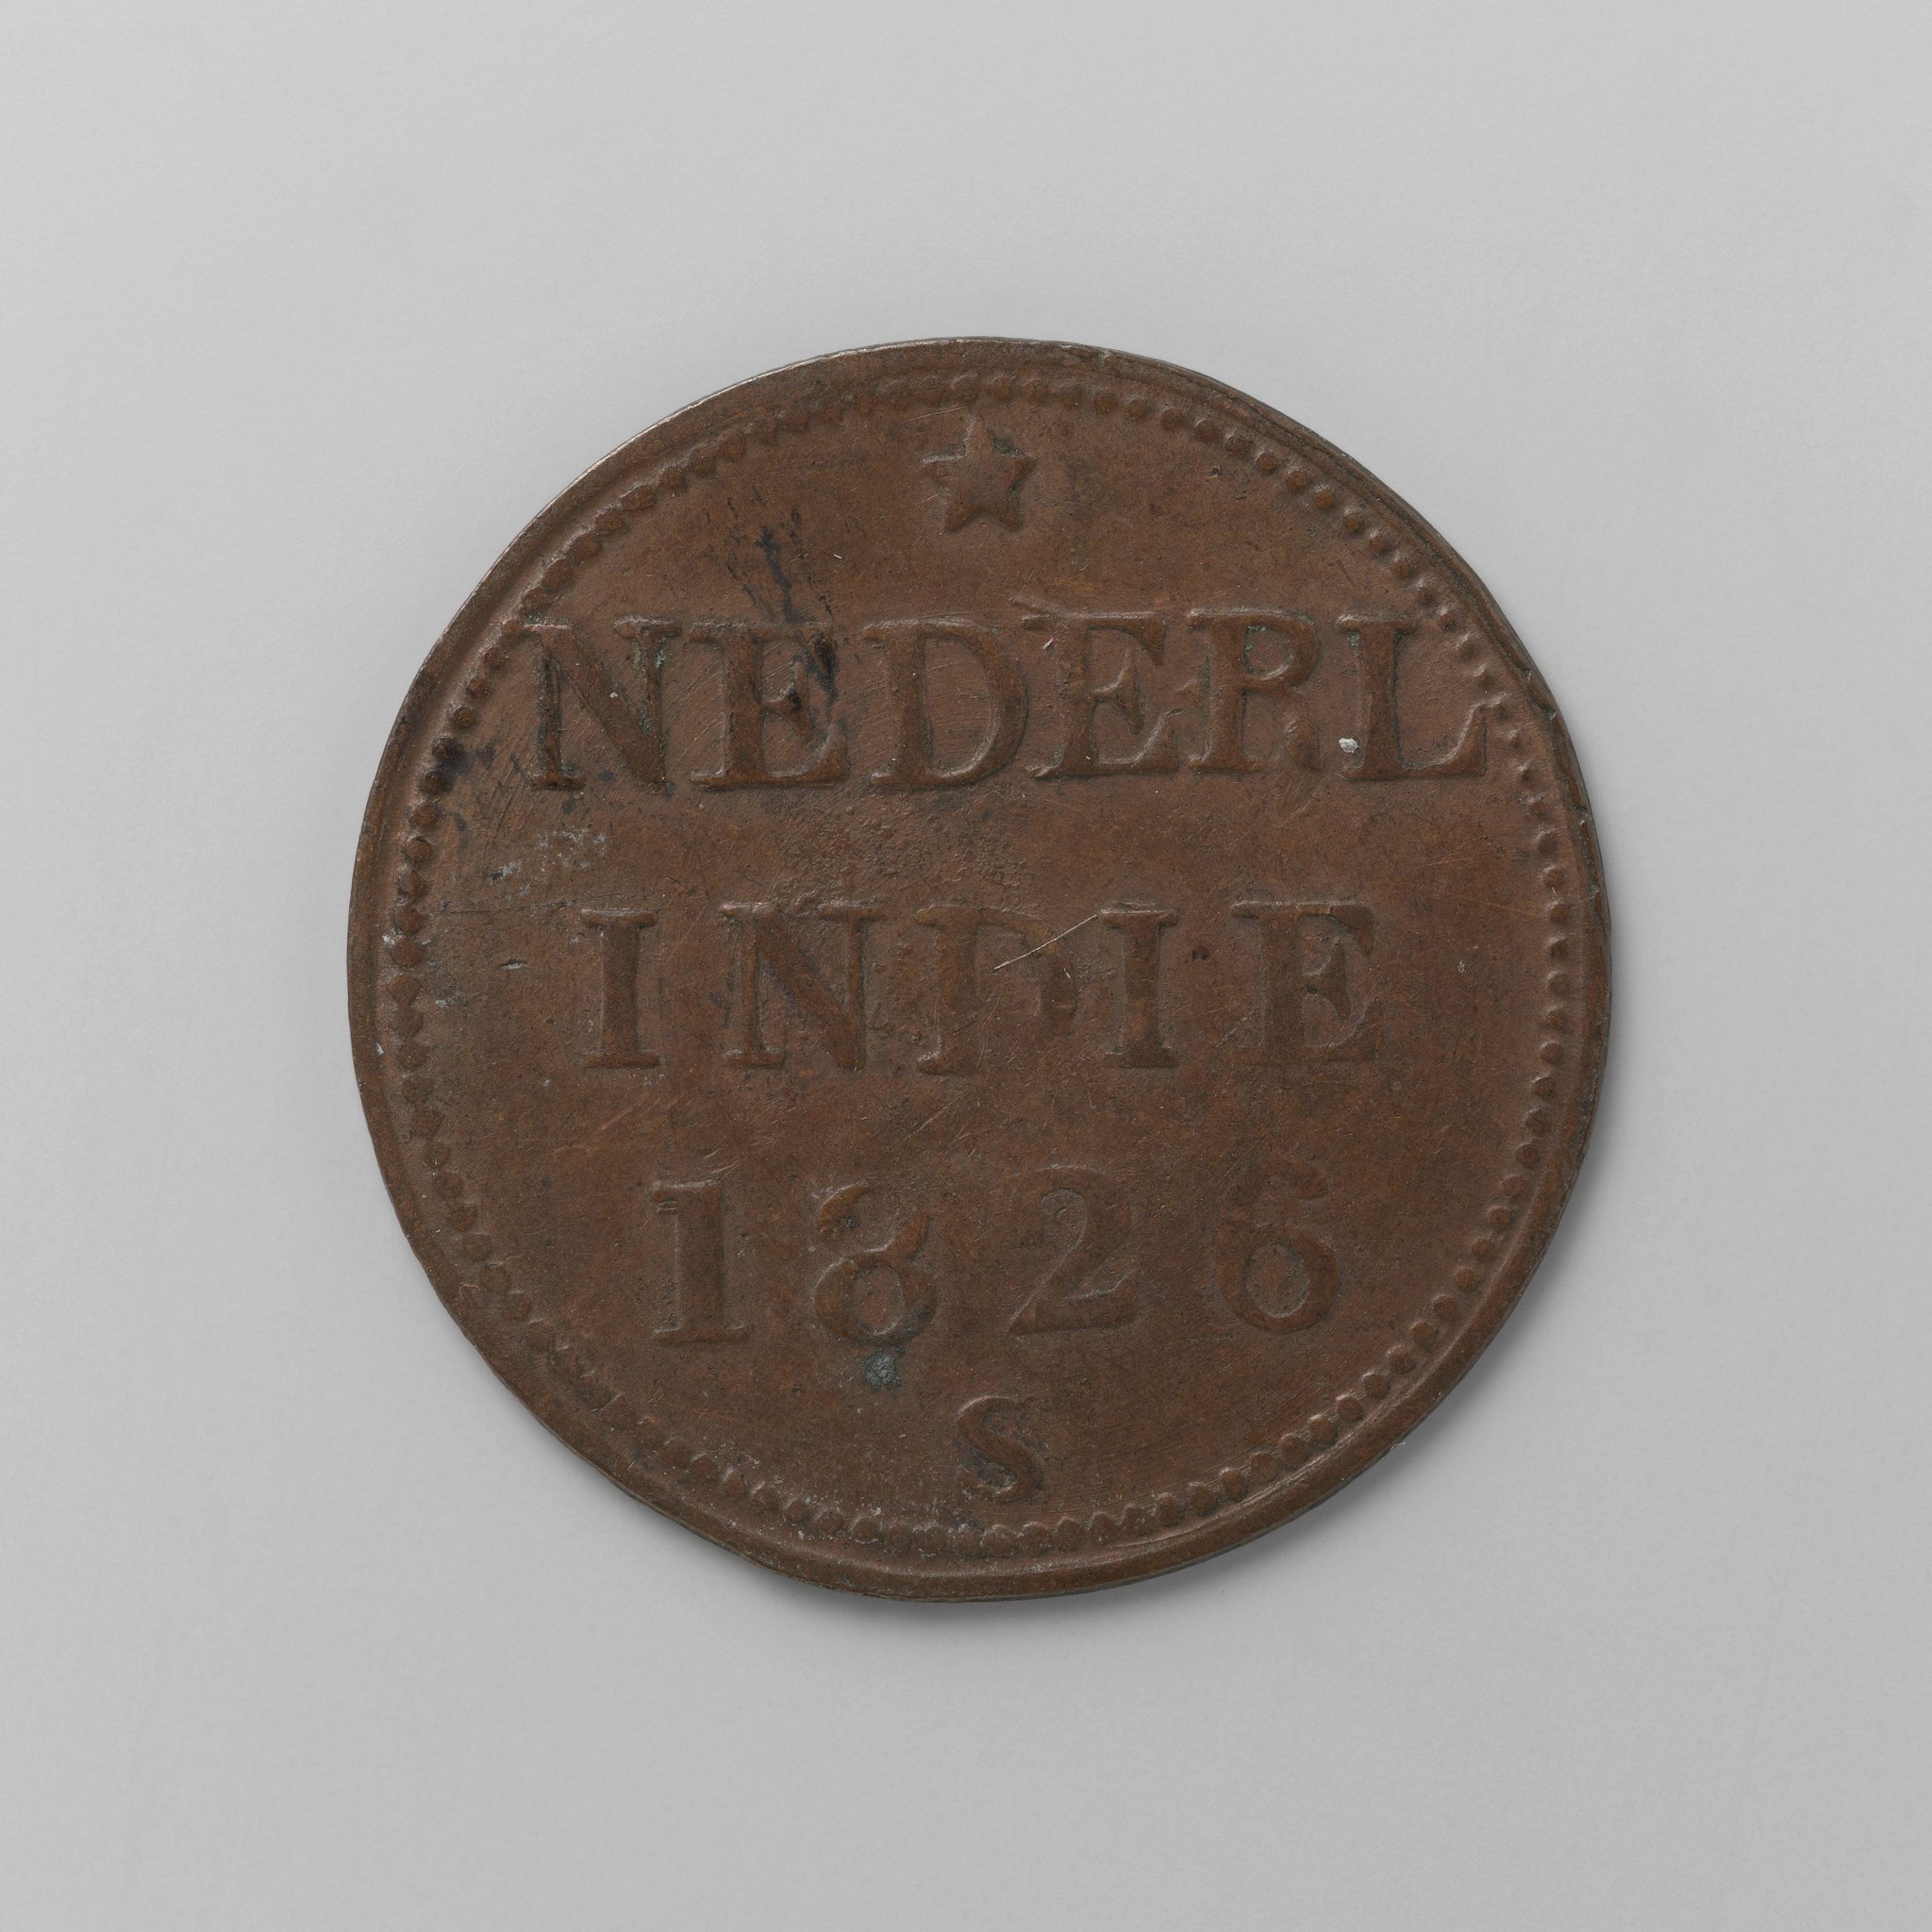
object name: coin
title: Engelse vervalsing van een 1/4 stuiver van Nederlands Indië,1826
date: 1826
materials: copper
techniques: striking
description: Koperen munt. Voorzijde: tussen waarde-aanduiding 1/4 St. gekroond rijkswapenschild. Keerzijde: tweeregelig opschrift, waarboven muntteken en waaronder jaartal. Daaronder letter S. Voorzijde en keerzijde versierd met partelrand. Gladde rand. Engelse vervalsing.